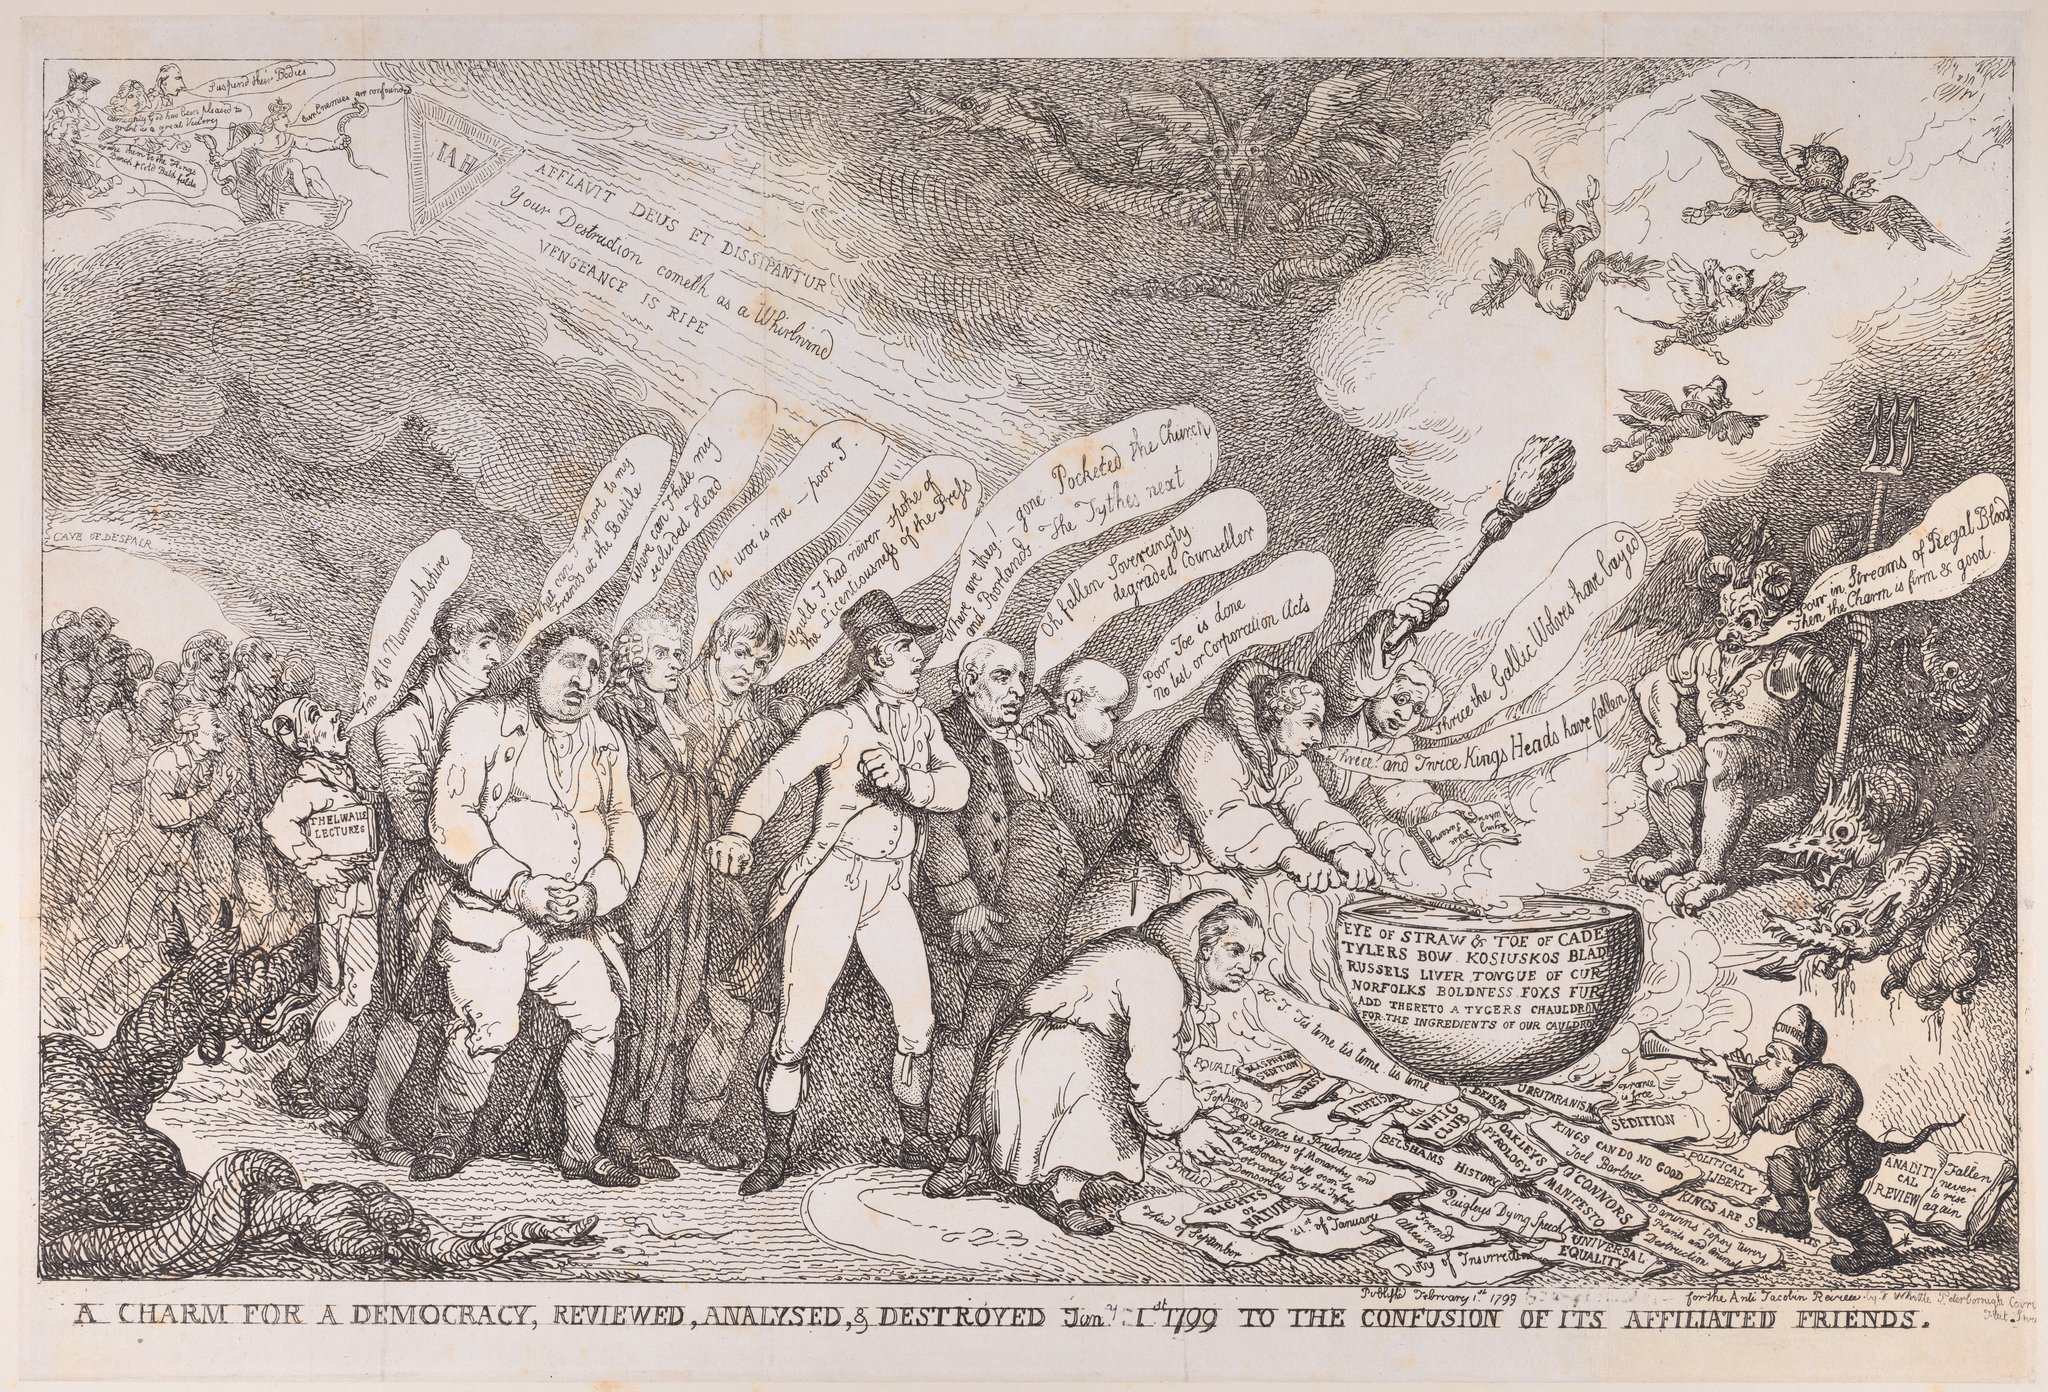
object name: print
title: A Charm for a Democracy, Reviewed, Analysed, & Destroyed Jan 1 1799 to the Confusion of its Affiliated Friends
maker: henri merke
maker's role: artist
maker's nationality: swiss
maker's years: 1760-1820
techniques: etching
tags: satire,men